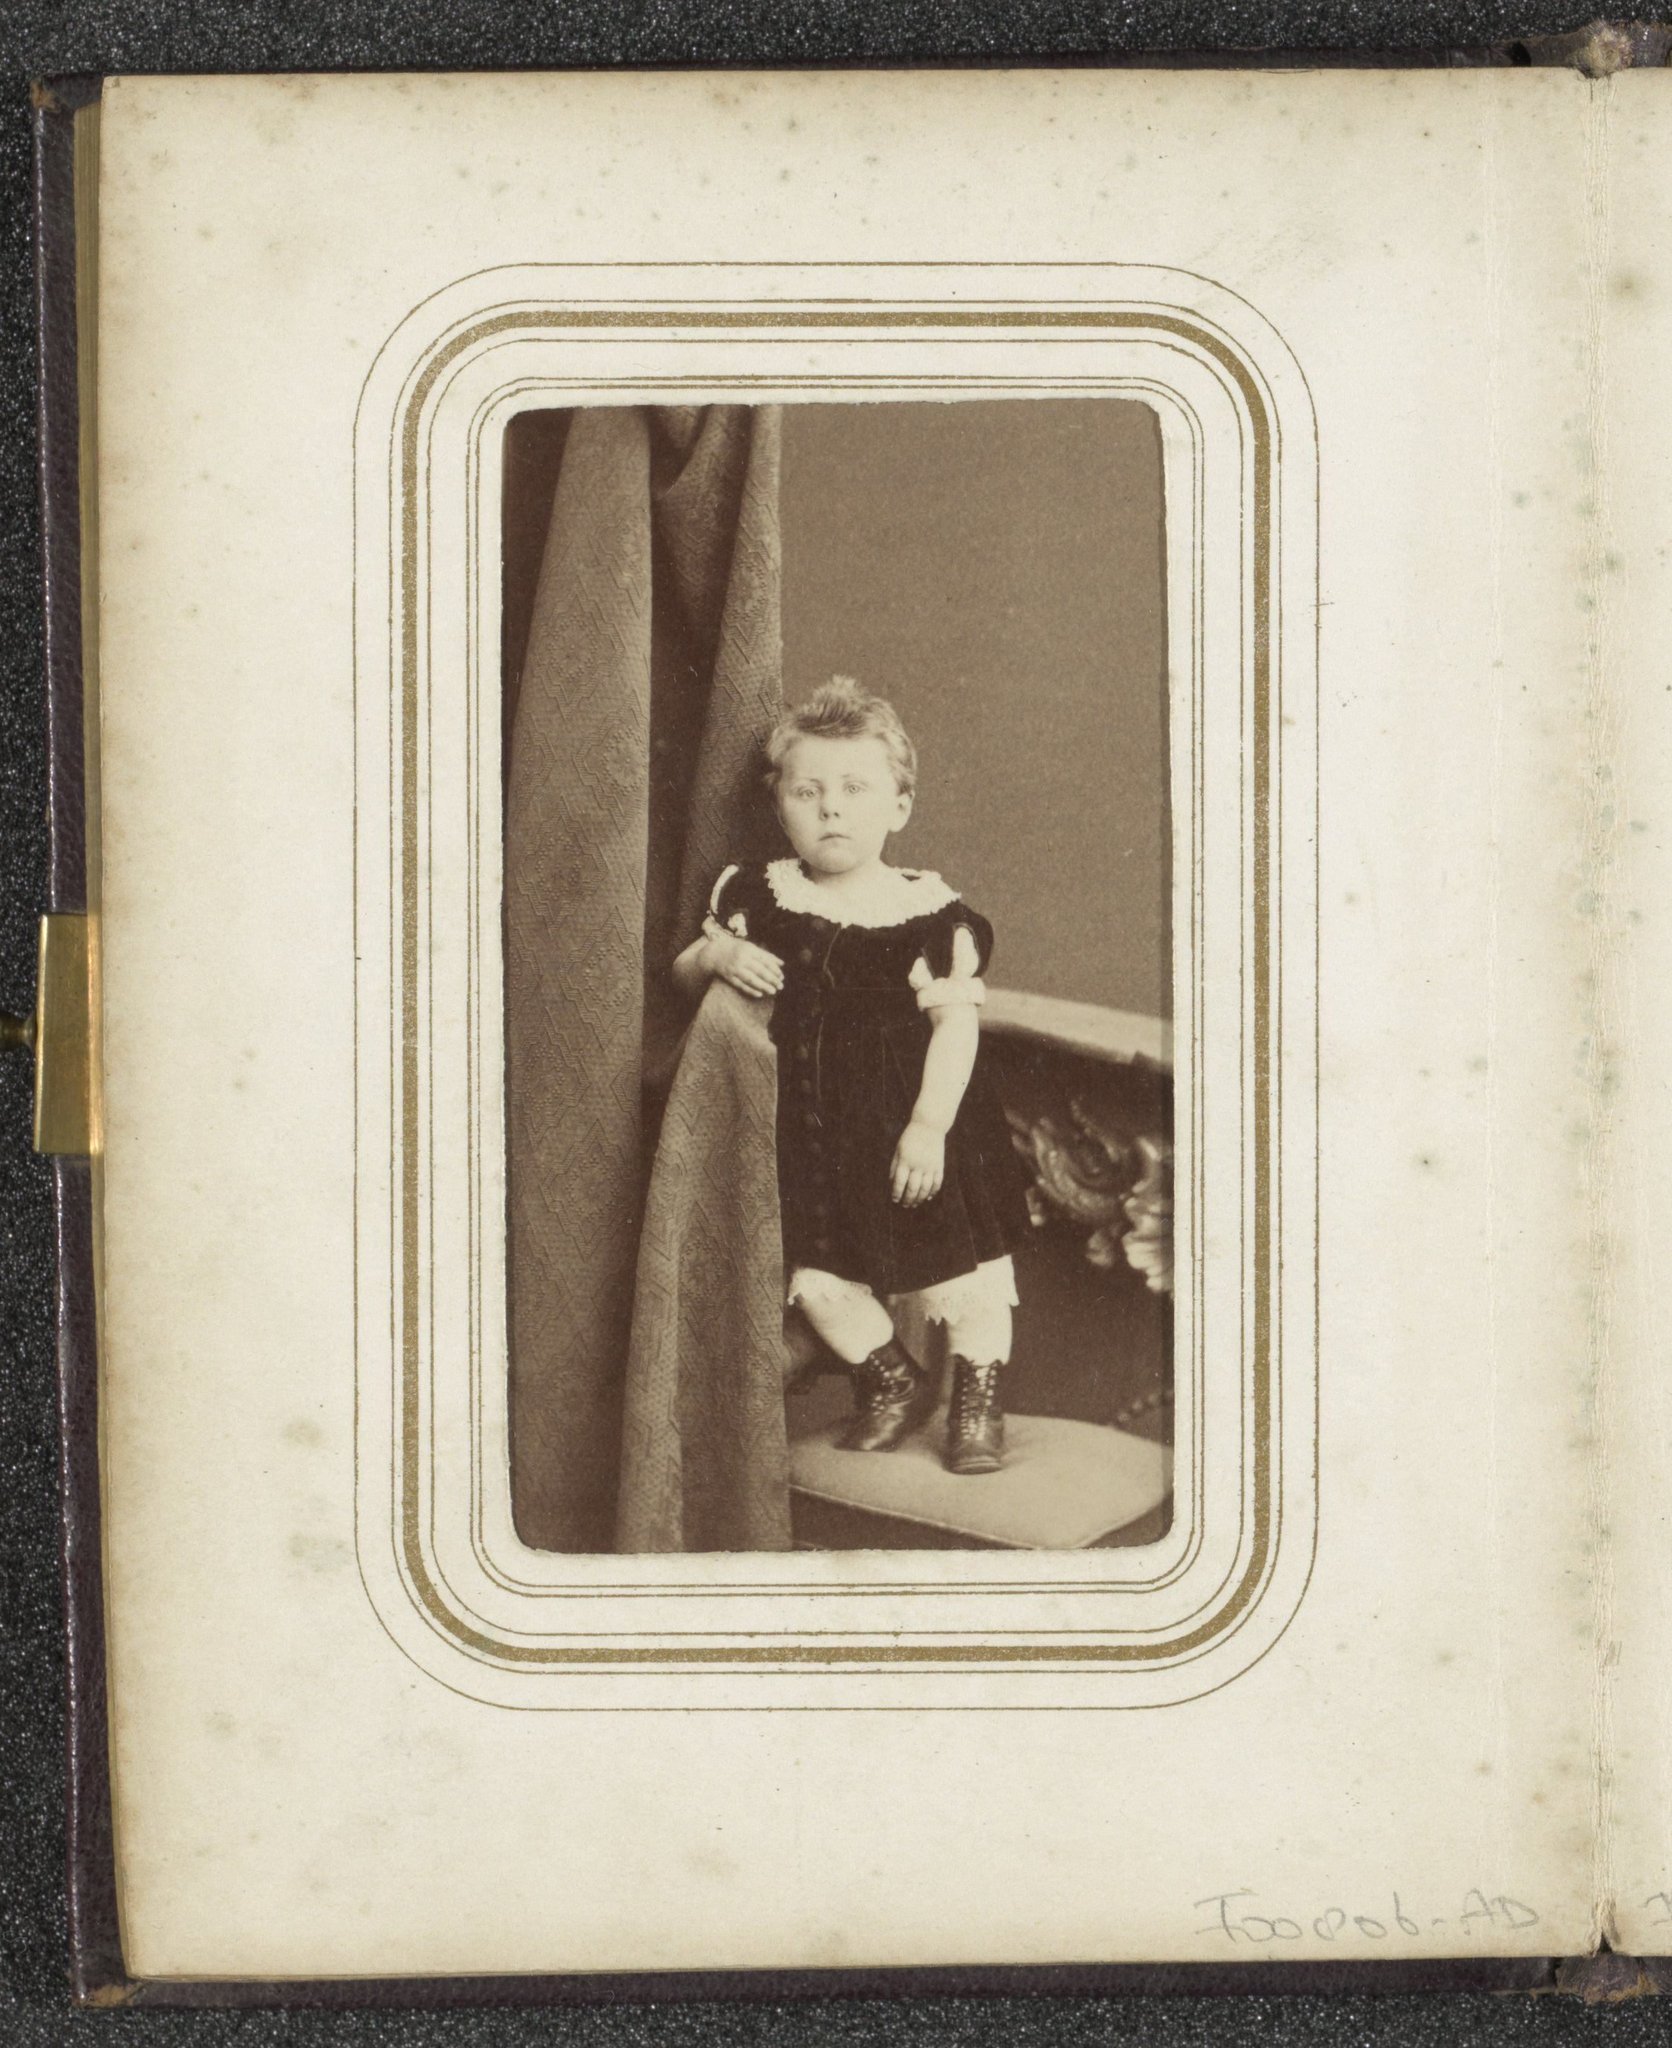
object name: carte de visite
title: Portret van een kleuter in een jurk, staand op een stoel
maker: f.j. engelmann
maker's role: fotograaf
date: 1865-1880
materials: cardboard, paper, photographic support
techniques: albumen print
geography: krefeld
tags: studio requisites ~ photographer, child, historical persons, boots, dress, gown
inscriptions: check stamp: ‘Engelmann, F.J.’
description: Onderdeel van Fotoalbum met 36 cartes-de-visite van Nederlandse personen.